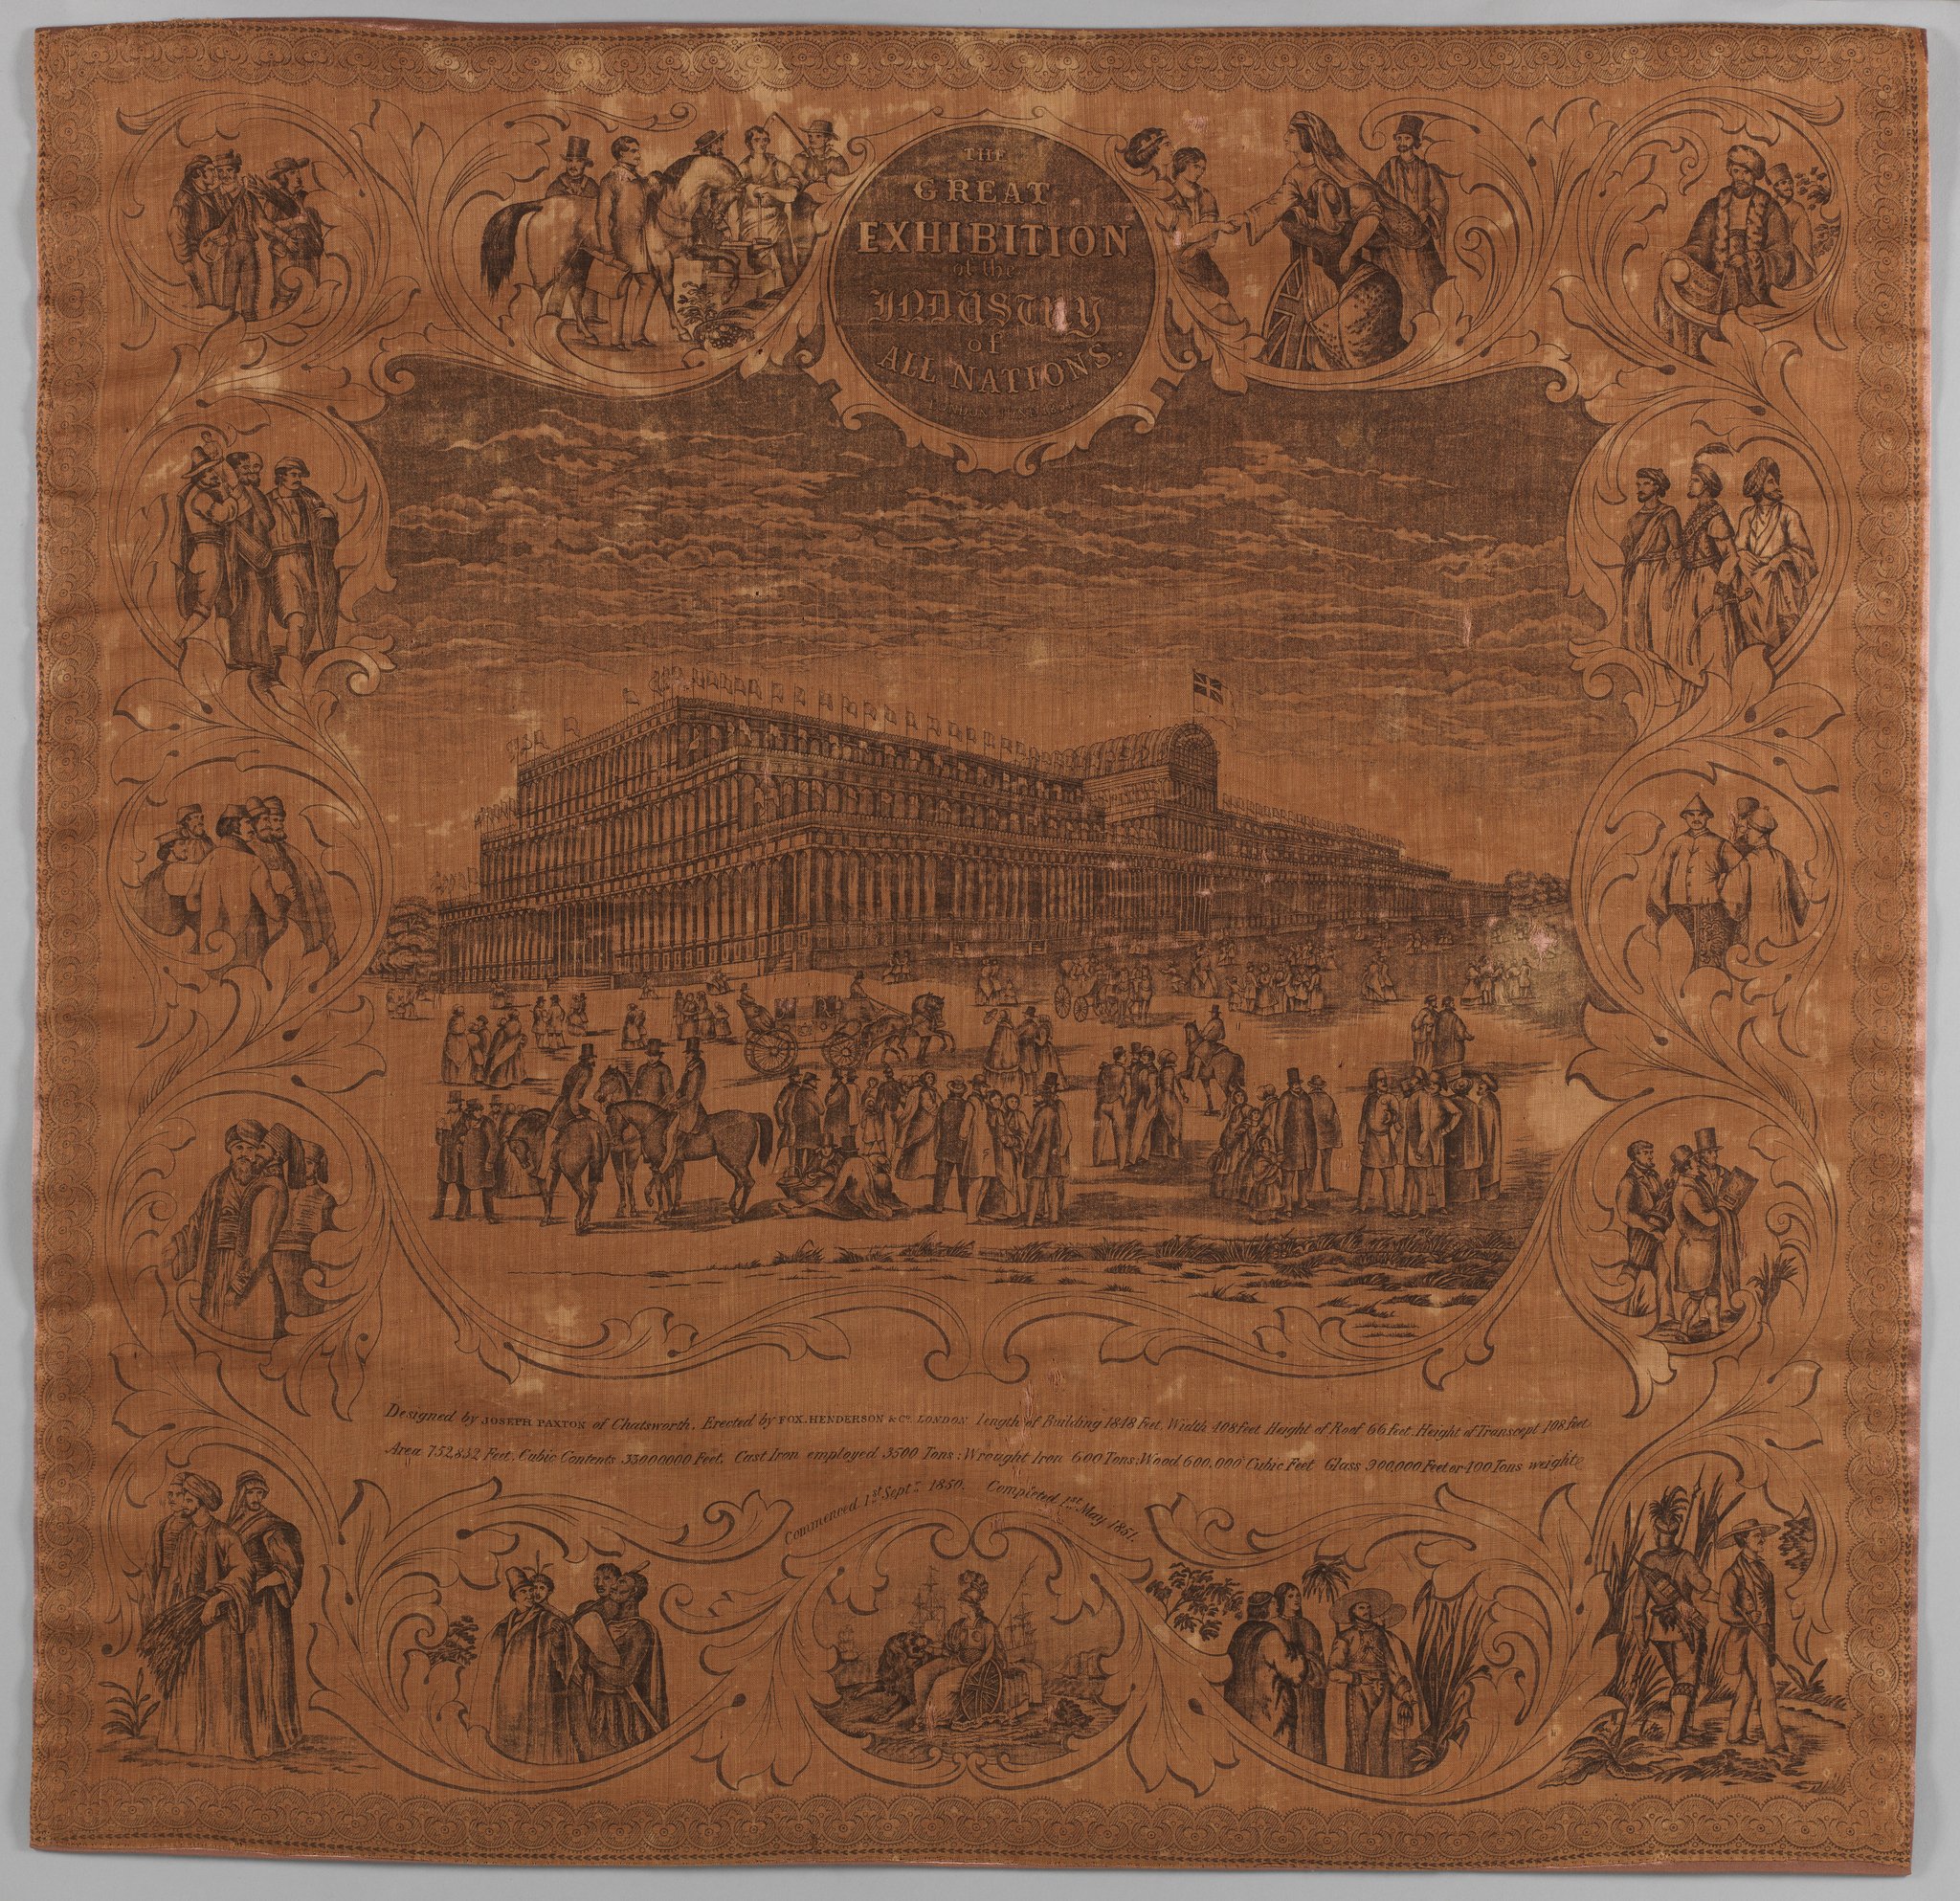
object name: handkerchief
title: Event handkerchief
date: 1851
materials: cotton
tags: buildings,men,women,horses,carriages